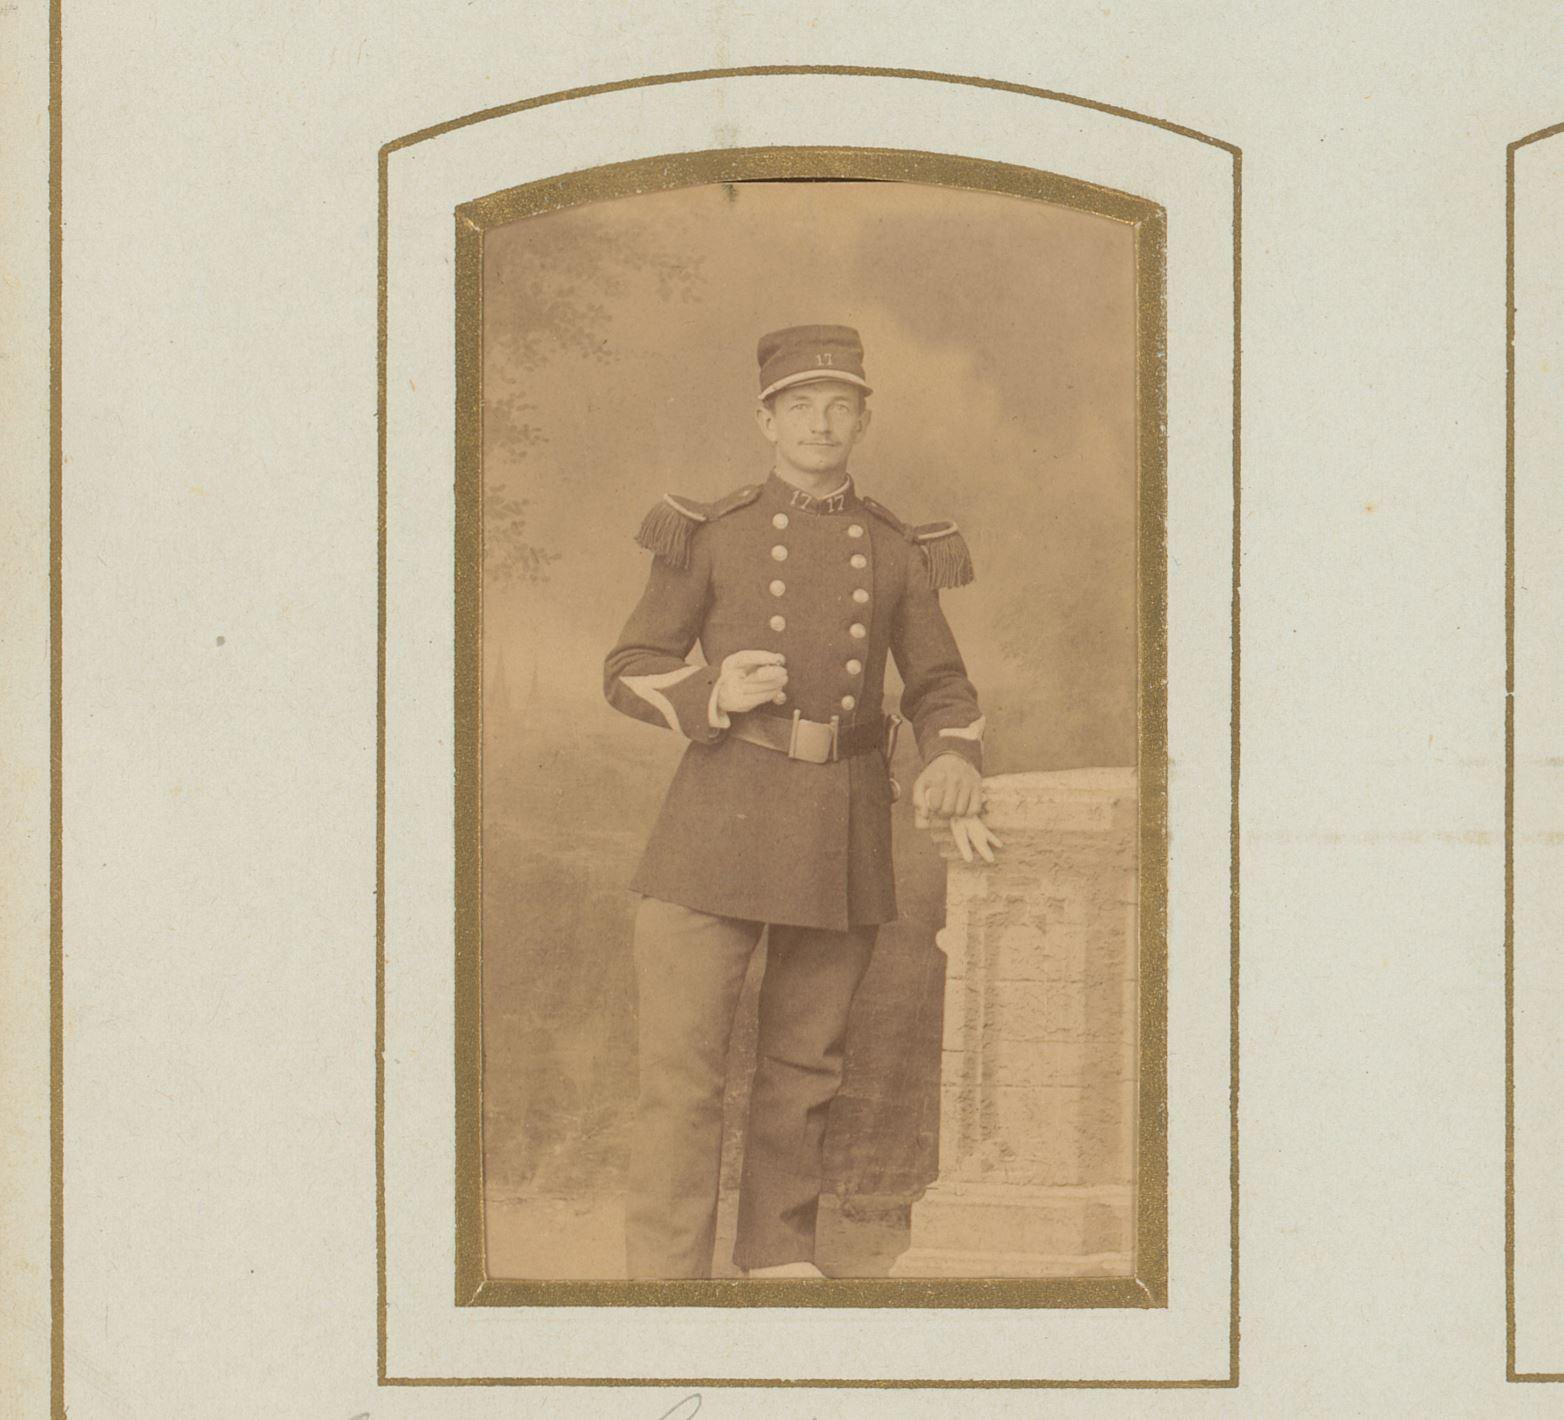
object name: photograph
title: Portret van Eugène Lanchir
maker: alphonse locquier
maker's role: fotograaf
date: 1880-1920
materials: cardboard, photographic support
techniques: collodion silver print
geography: rambervillers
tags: historical persons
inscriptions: name: ‘Eugène Lanchir - Adjudant/ au 17e chasseurs/ +1936’